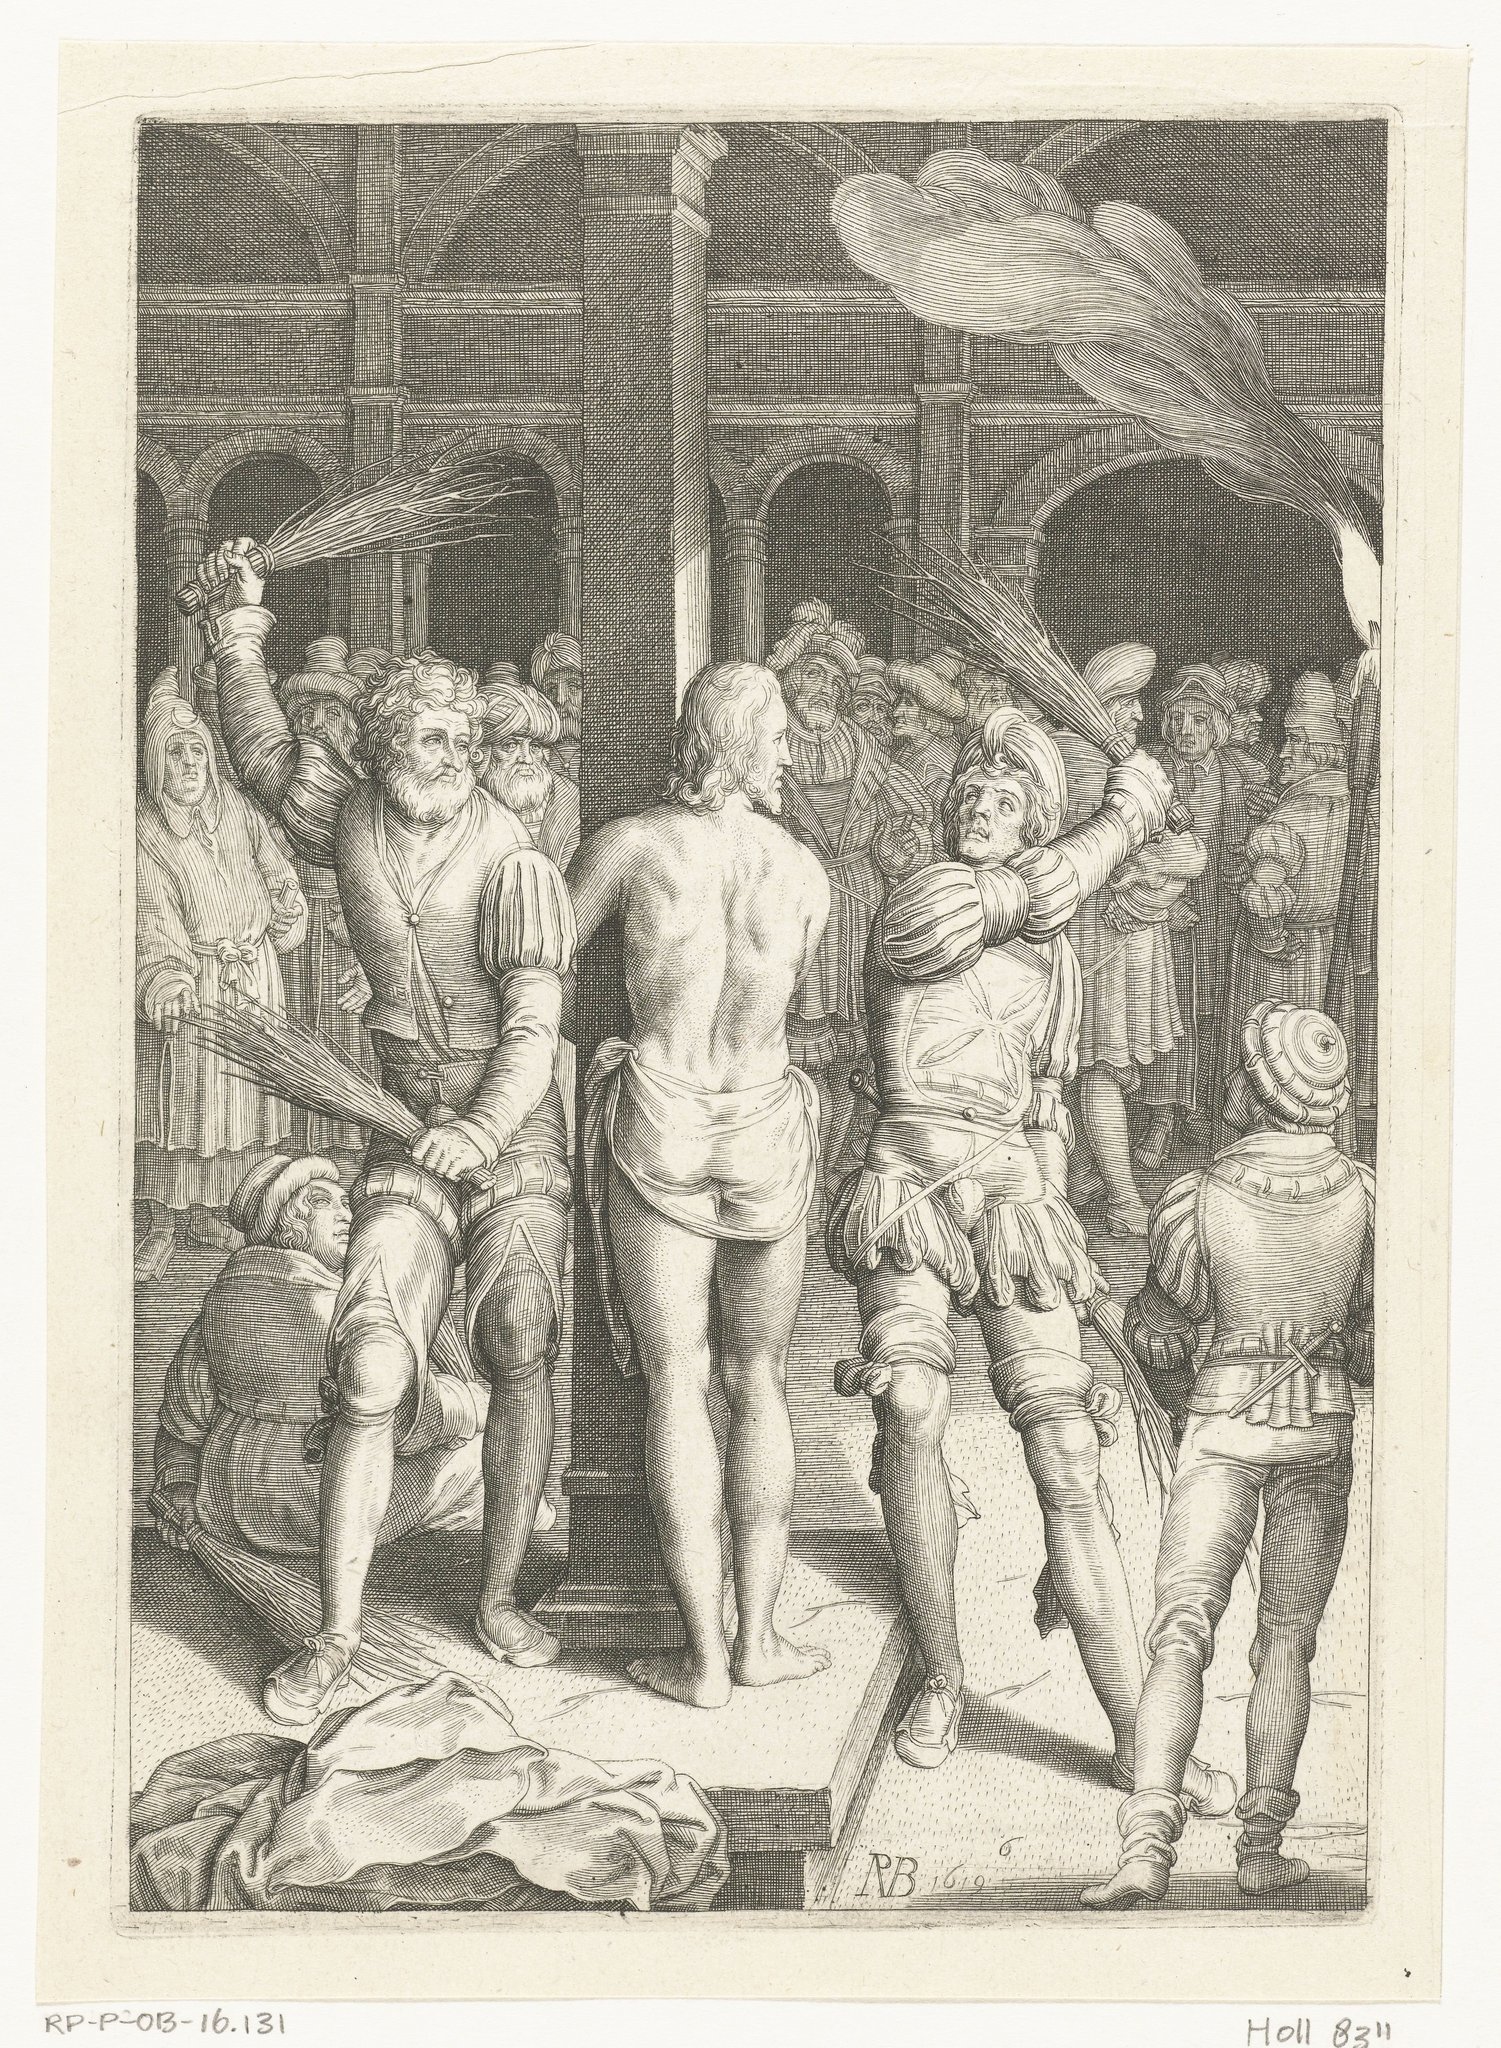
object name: print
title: De Passie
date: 1619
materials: paper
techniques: engraving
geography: netherlands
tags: flagellation by soldiers, christ usually tied to a column (matthew 27:26; mark 15:15; john 19:1)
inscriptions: collector's mark: Lugt 2228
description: Prent uit serie van twaalf prenten met scènes uit de Passie. Reeks geïnspireerd door de prenten van Hendrick Goltzius en Lucas van Leyden.